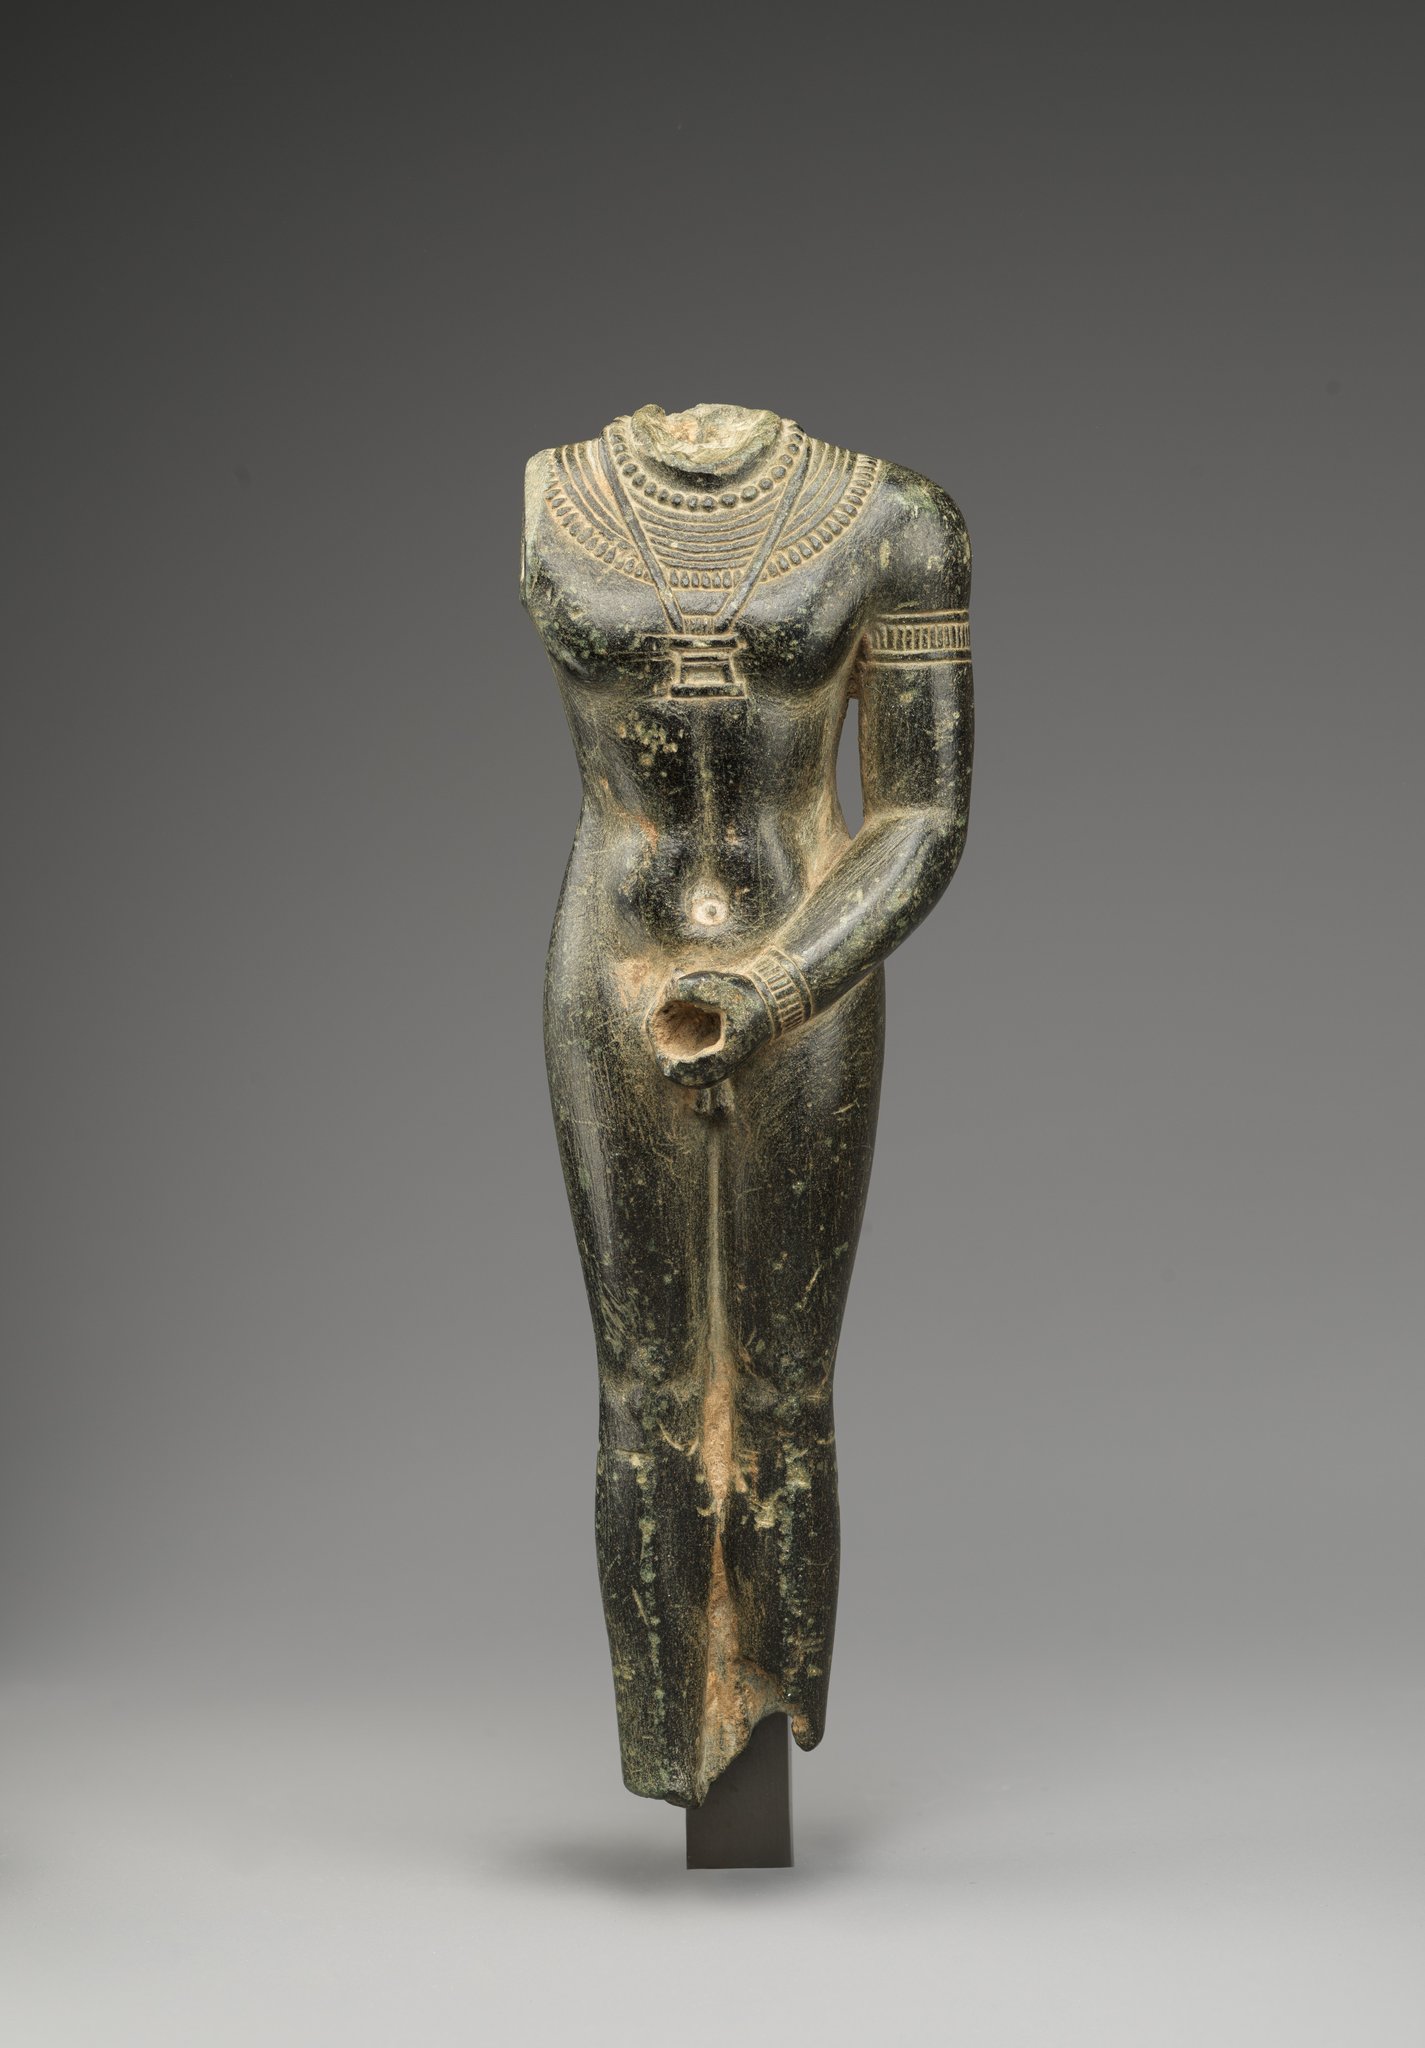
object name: statue, min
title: Headless unshrouded ithyphallic deity statuette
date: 332-330 BCE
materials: stone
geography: egypt